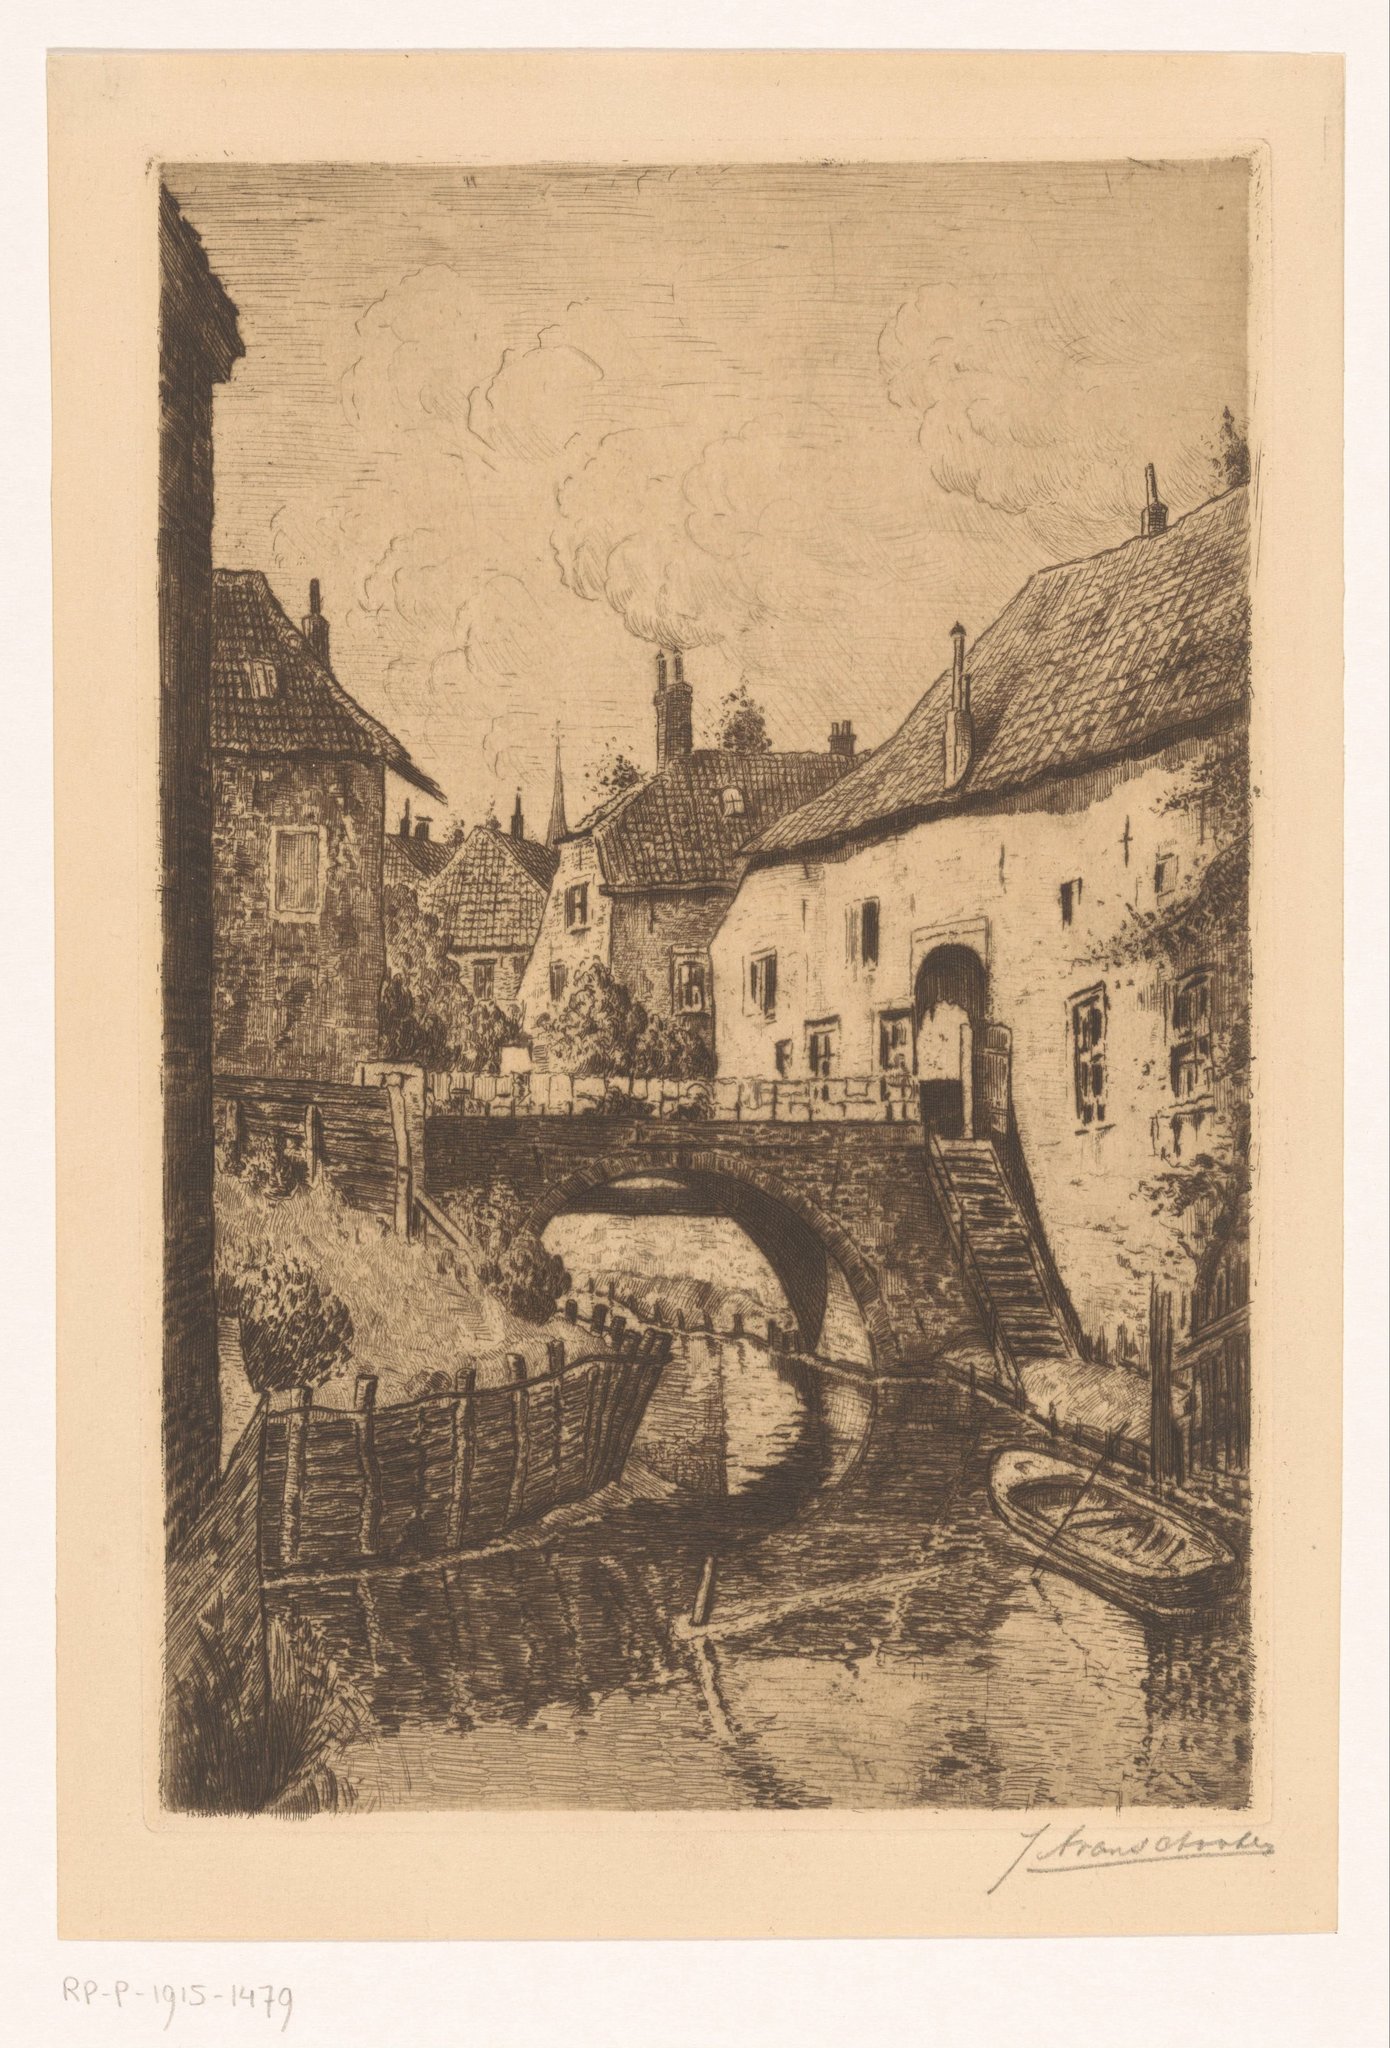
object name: print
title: Gezicht op een brug bij de Zusters van Orthenpoort in Den Bosch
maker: jan antonius van schooten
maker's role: print maker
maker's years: 1870-1933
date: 1880-1915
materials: paper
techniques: etching, intaglio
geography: netherlands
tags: bridge in city across river, canal, etc., den bosch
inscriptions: collector's mark: Lugt 2233